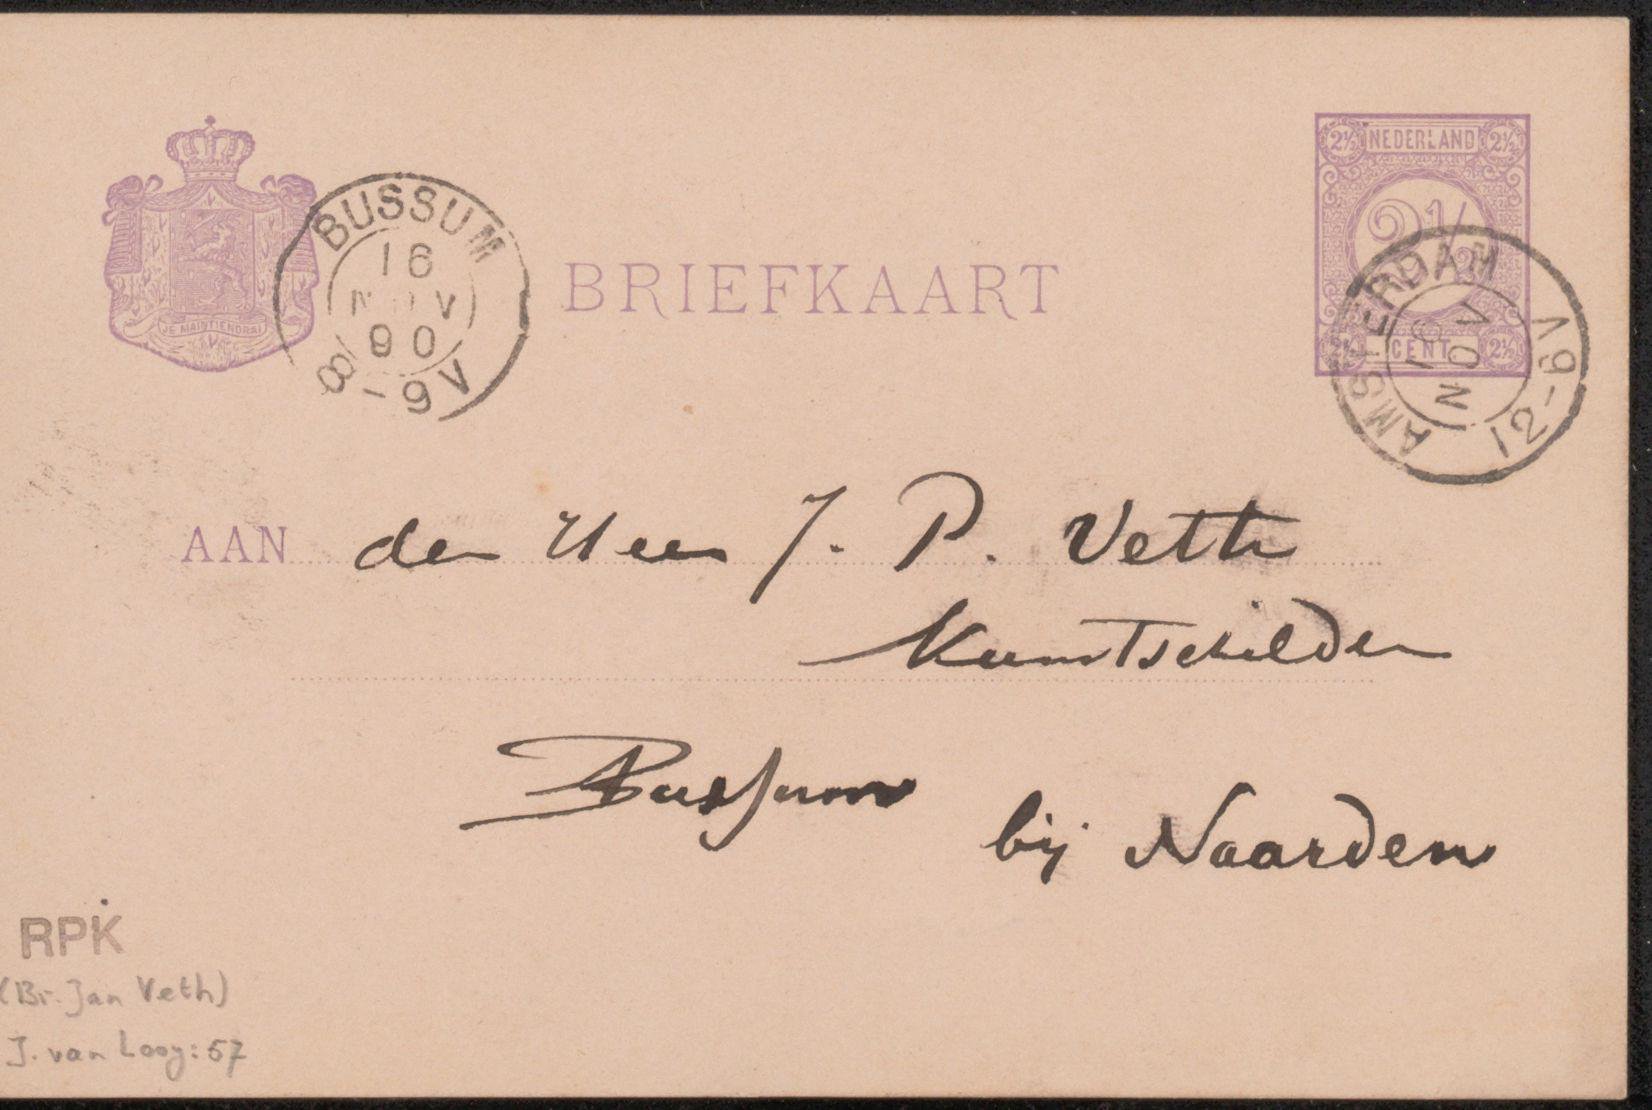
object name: postcard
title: Briefkaart aan Jan Veth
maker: jac van looij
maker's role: draughtsman, painter, print maker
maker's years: 1855-1930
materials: cardboard, ink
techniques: pen, writing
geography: amsterdam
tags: dordrecht, designer, jan veth, albert verwey, photography, cinematography, historical persons (portraits and scenes from the life)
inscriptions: collector's mark: ‘RPK’